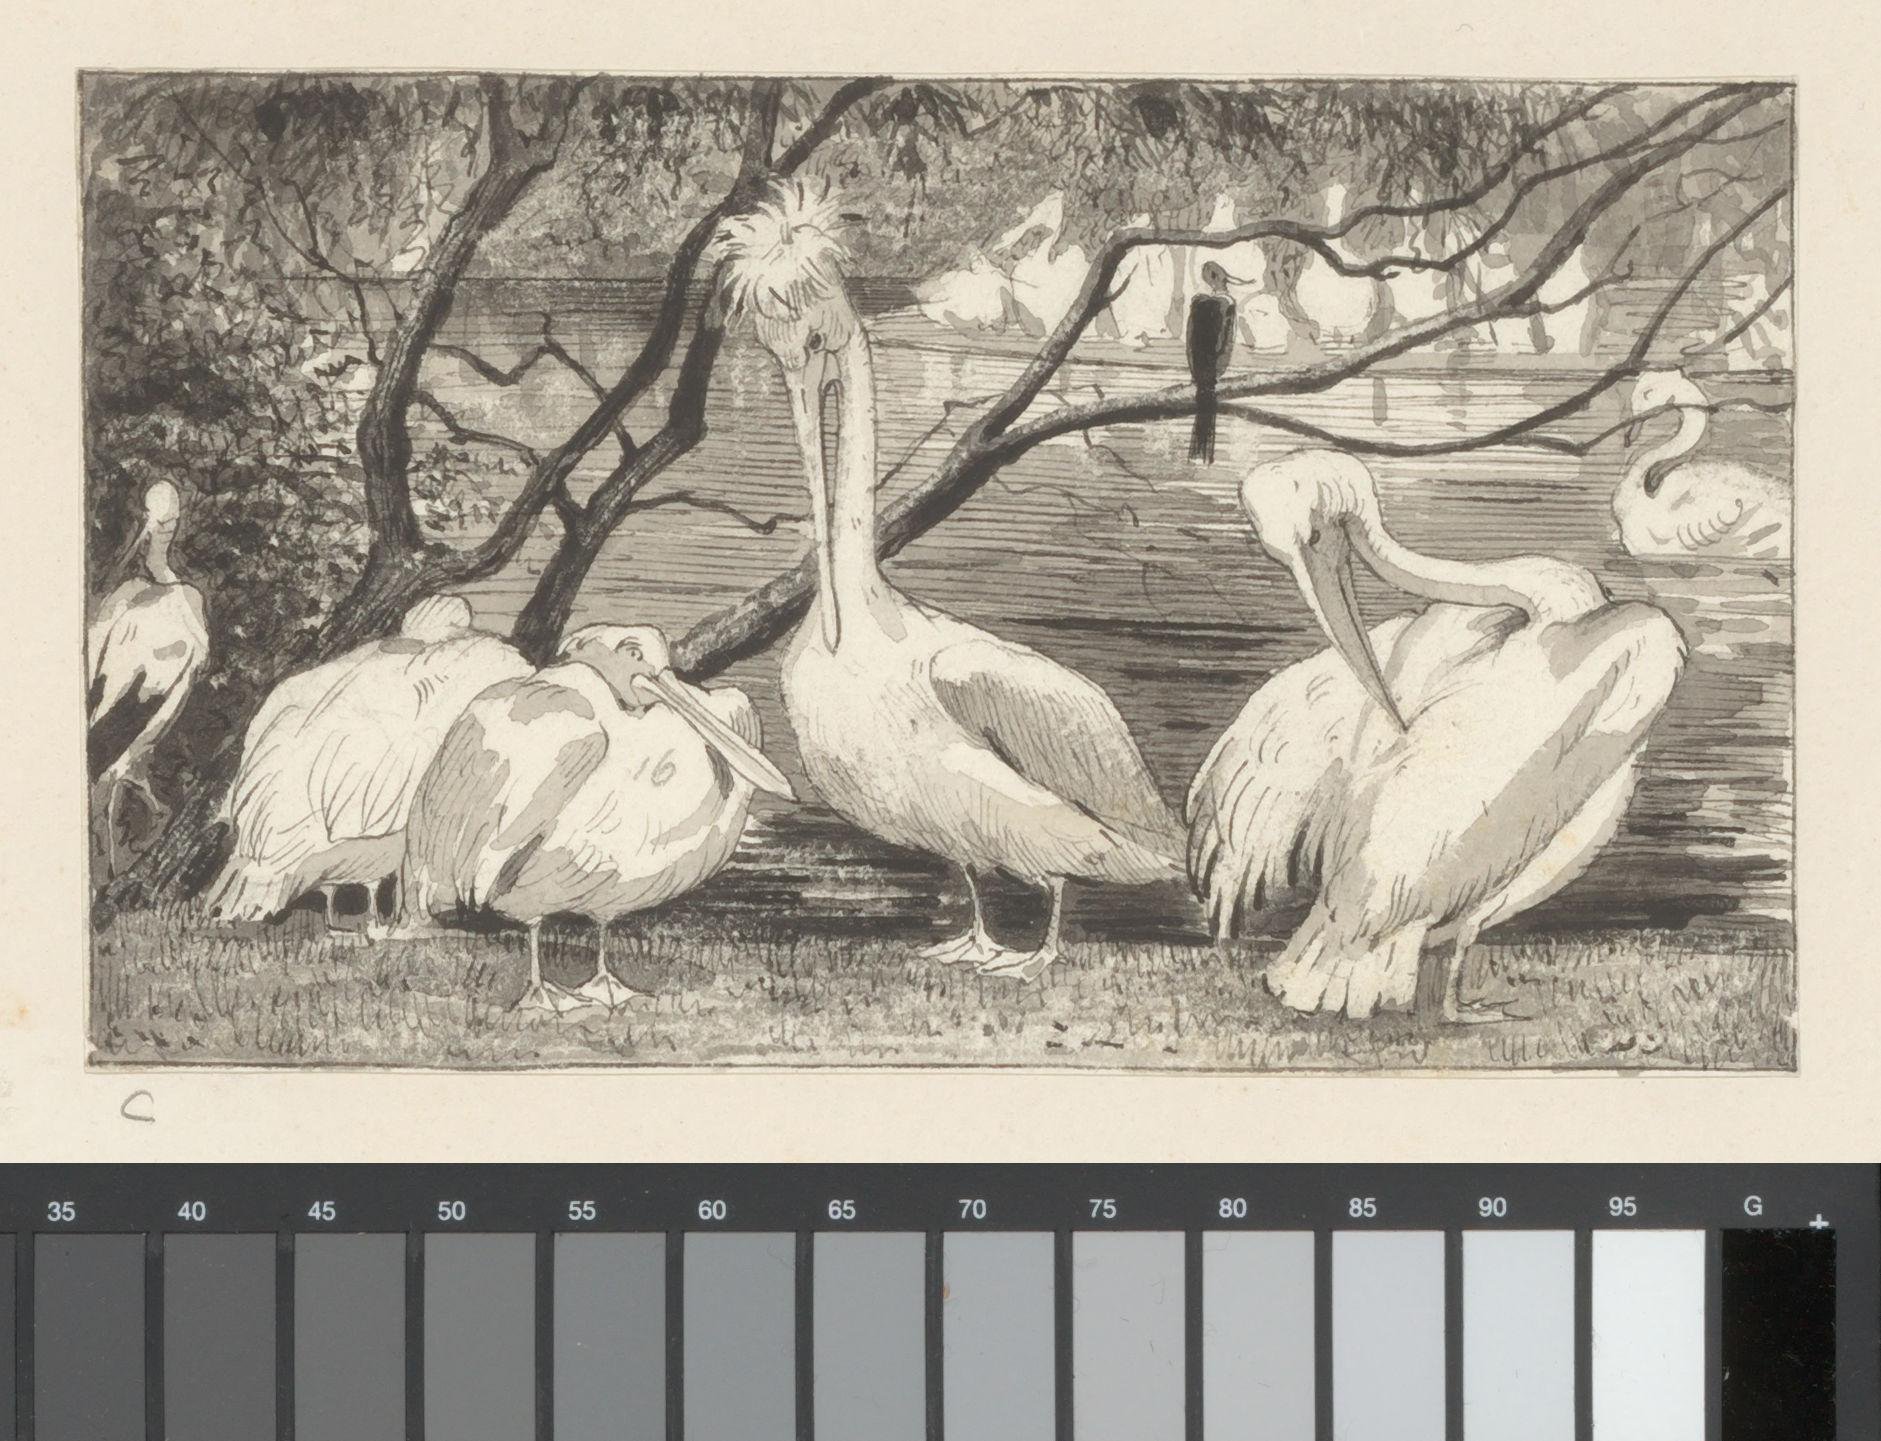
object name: drawing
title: Gezicht op het verblijf van de pelikanen in Artis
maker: friedrich wilhelm wittig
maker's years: 1854-1912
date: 1880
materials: ink, paper, pencil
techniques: brush, pen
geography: amsterdam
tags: city-view in general; 'veduta', zoo (as place of recreation)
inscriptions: name: ‘In Artis Natura Magistra. / F. Wittig fecit.’, collector's mark: ‘51B / VDE 8.12.'86’, number: ‘75’, inscription: ‘Legaat Joh. M. Coffeng / 1966’, inscription: ‘Fr. Wittig / Erinnerungen (...) No 462 / 1088’, inscription: ‘zie het boek (...) 22 N. 689’